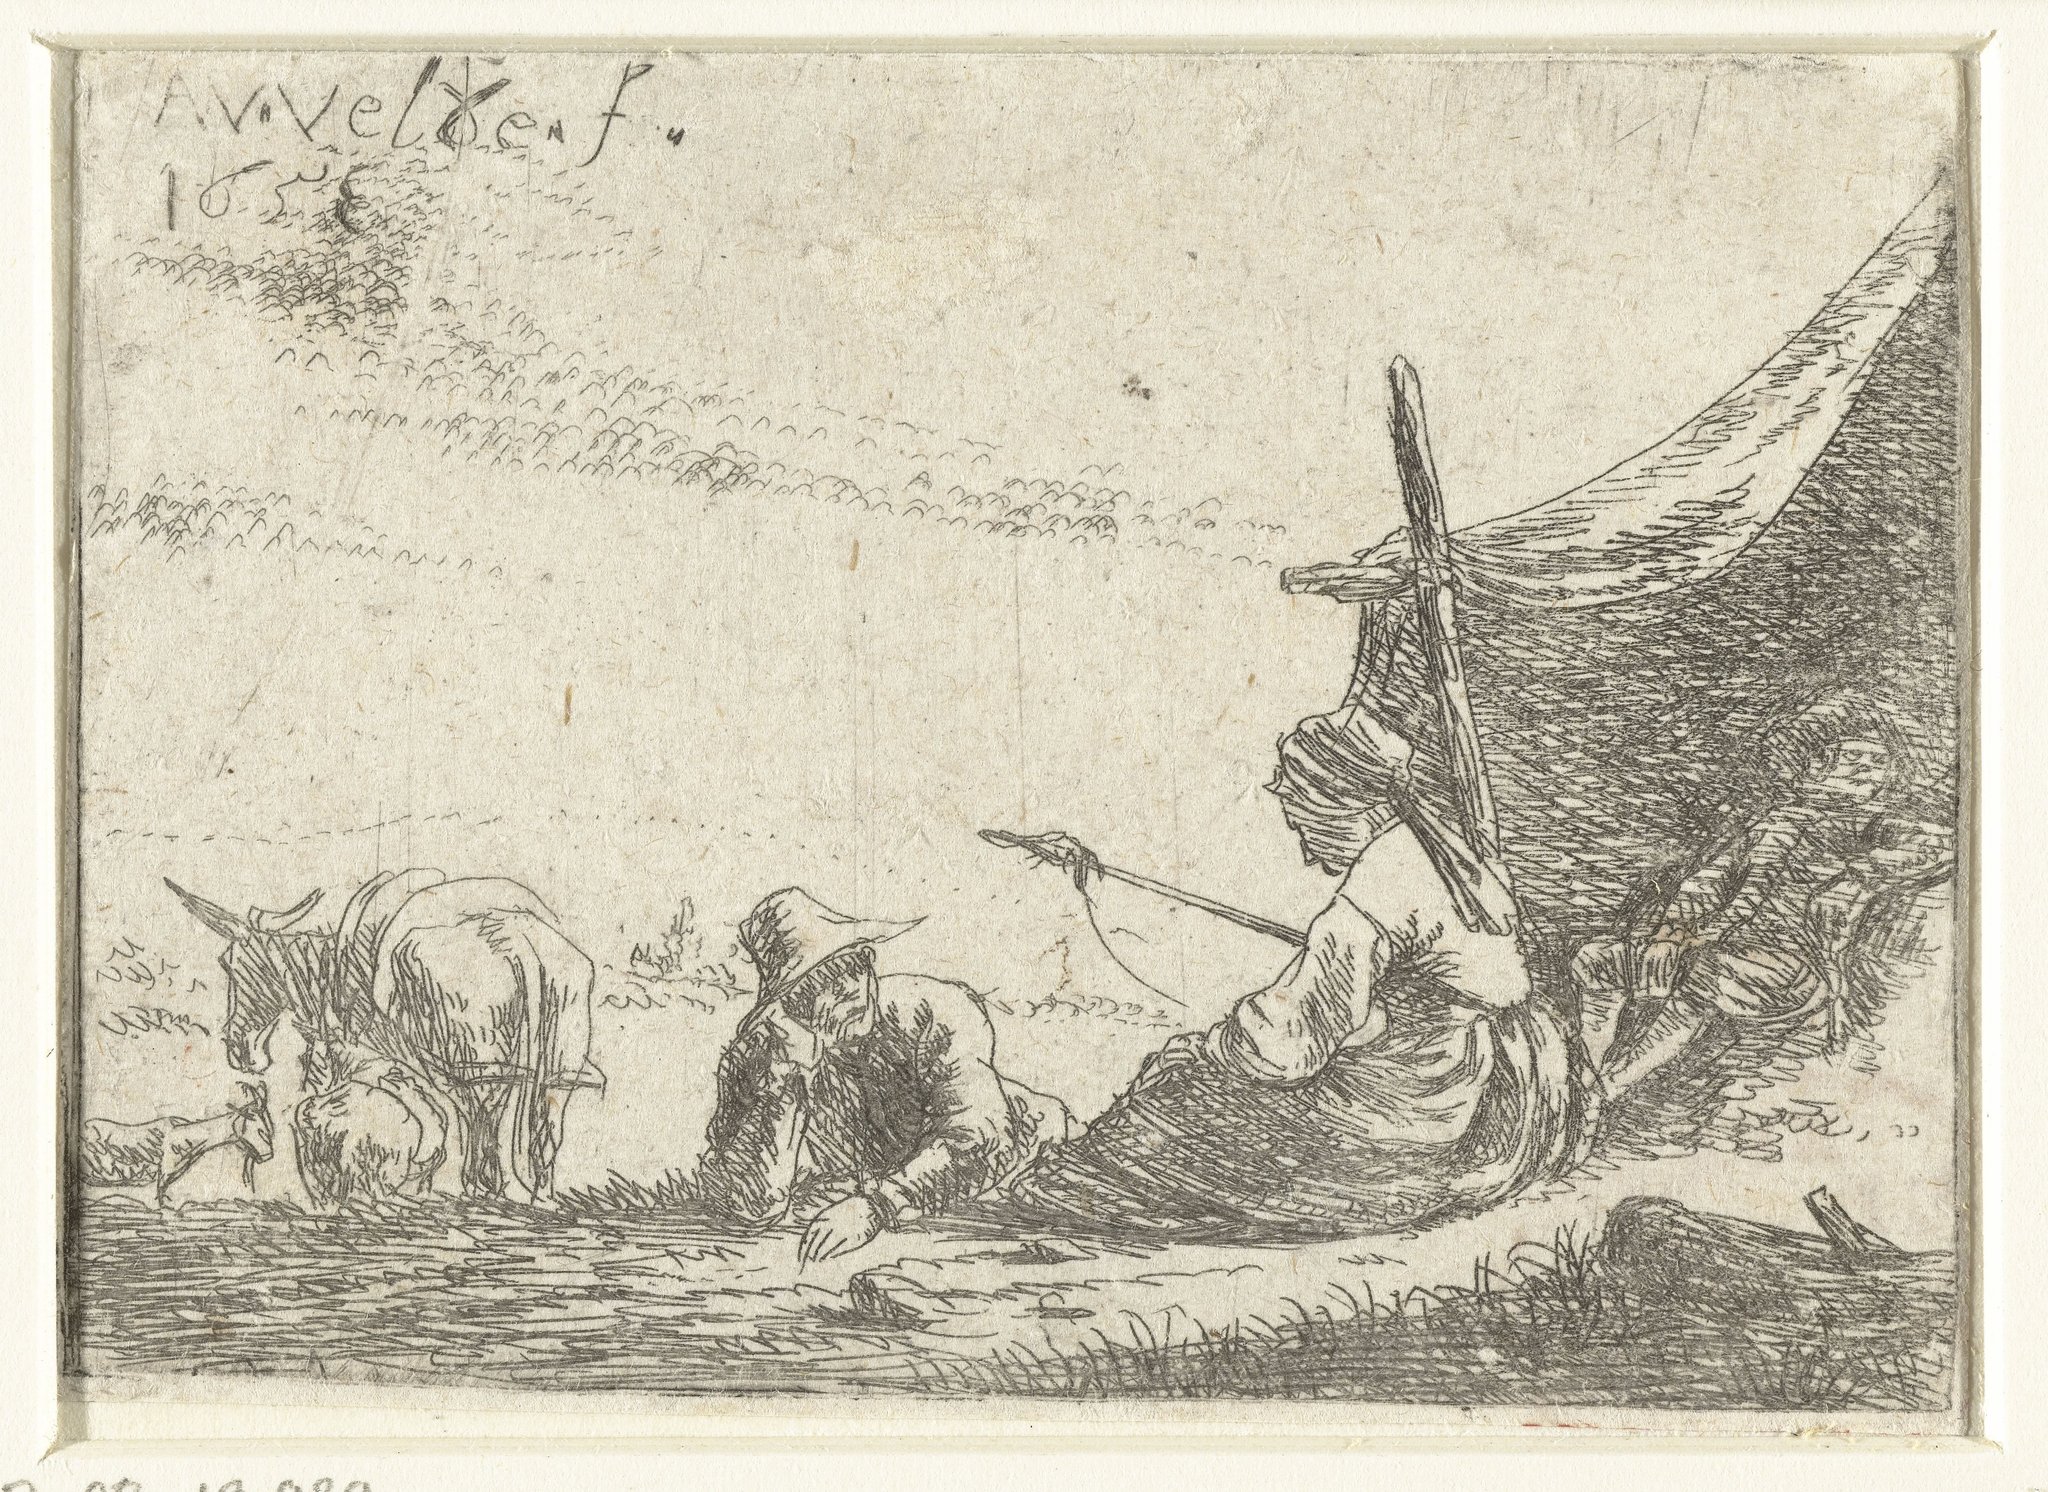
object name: print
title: Spinnende vrouw met twee mannen bij een tent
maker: adriaen van de velde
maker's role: draughtsman, painter, print maker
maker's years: 1636-1672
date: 1653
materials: paper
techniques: etching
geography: amsterdam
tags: tent, female sex; woman, brick-layer at work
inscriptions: collector's mark: ‘F. Rechberger 1818’ Lugt 2133, collector's mark: Lugt 12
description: Deze prent wordt beschouwd als een pendant van Drie jagers met honden. De twee prenten zijn beide in 1653 gedateerd en hebben bijna hetzelfde formaat.